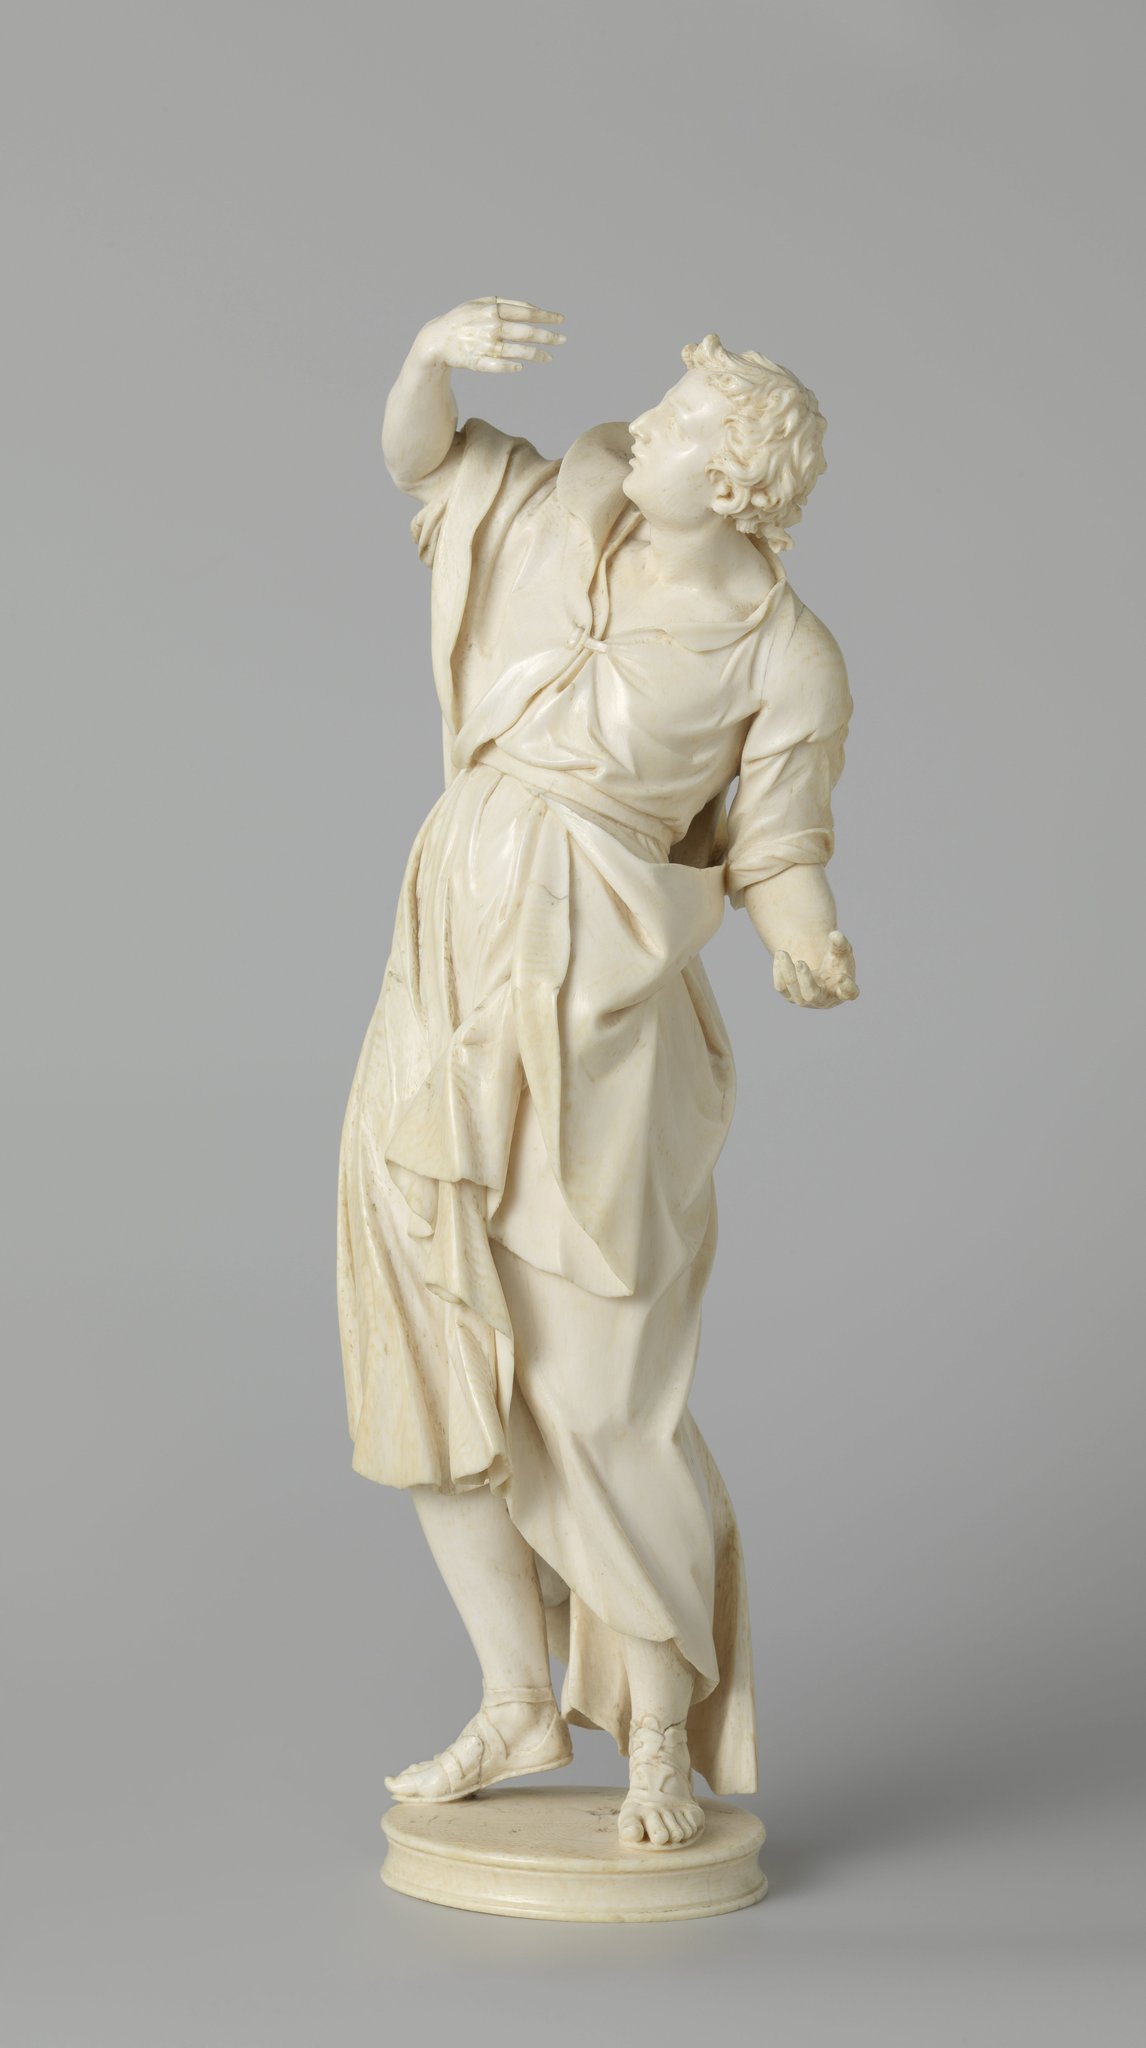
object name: figure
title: The Virgin and St John the Evangelist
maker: mattheus van beveren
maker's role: ivory carver, sculptor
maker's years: 1630-1690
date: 1670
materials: ivory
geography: brussels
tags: the apostle john the evangelist; possible attributes: book, cauldron, chalice with snake, eagle, palm, scroll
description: The figures of the Virgin and the Apostle John originally flanked a crucified Christ. The Virgin is represented with an expression of intense sorrow, while he gazes upwards in dismay. Her masterfully carved, flowing robes and her face were inspired by the Italian Baroque. John’s dynamic pose is derived from a famous sculptural group from Classical antiquity, the Laocoön.